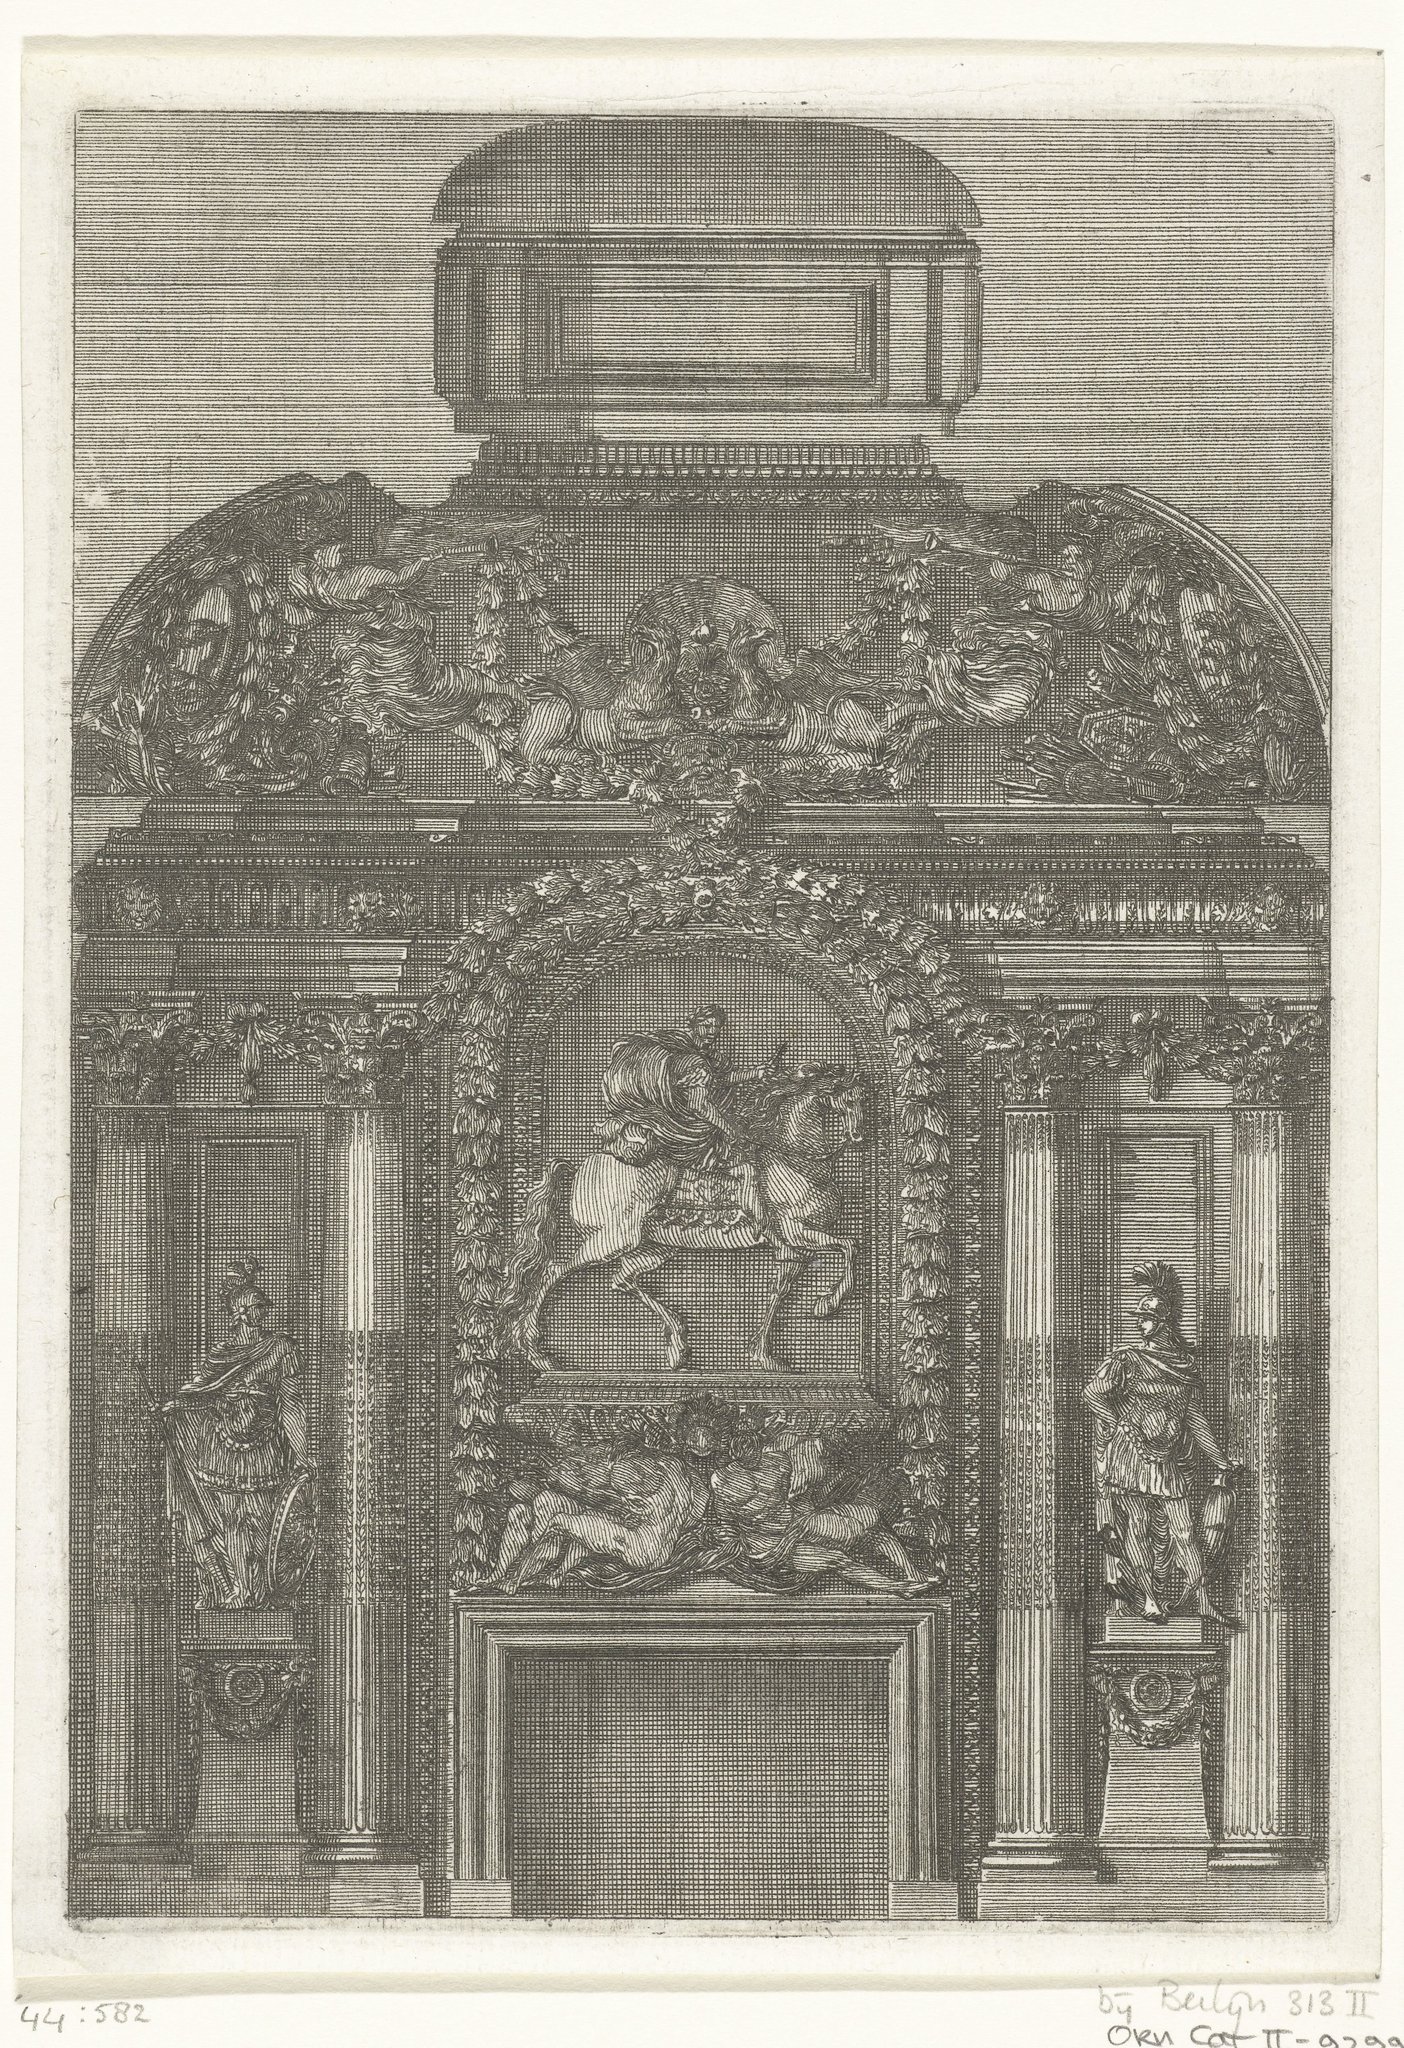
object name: print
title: Schoorsteen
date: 1651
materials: paper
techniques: etching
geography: paris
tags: chimney, chimney ornaments, slavery; serfs and enslaved persons, prisoner of war (after the battle)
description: In het midden staat een paardrijder afgebeeld boven vier geketende krijgsgevangenen of slaafgemaakte mannen, aan de zijkanten verzonken Korintische zuilen met het beeld van een Romeinse generaal ertussen. Uit serie van 12 bladen.